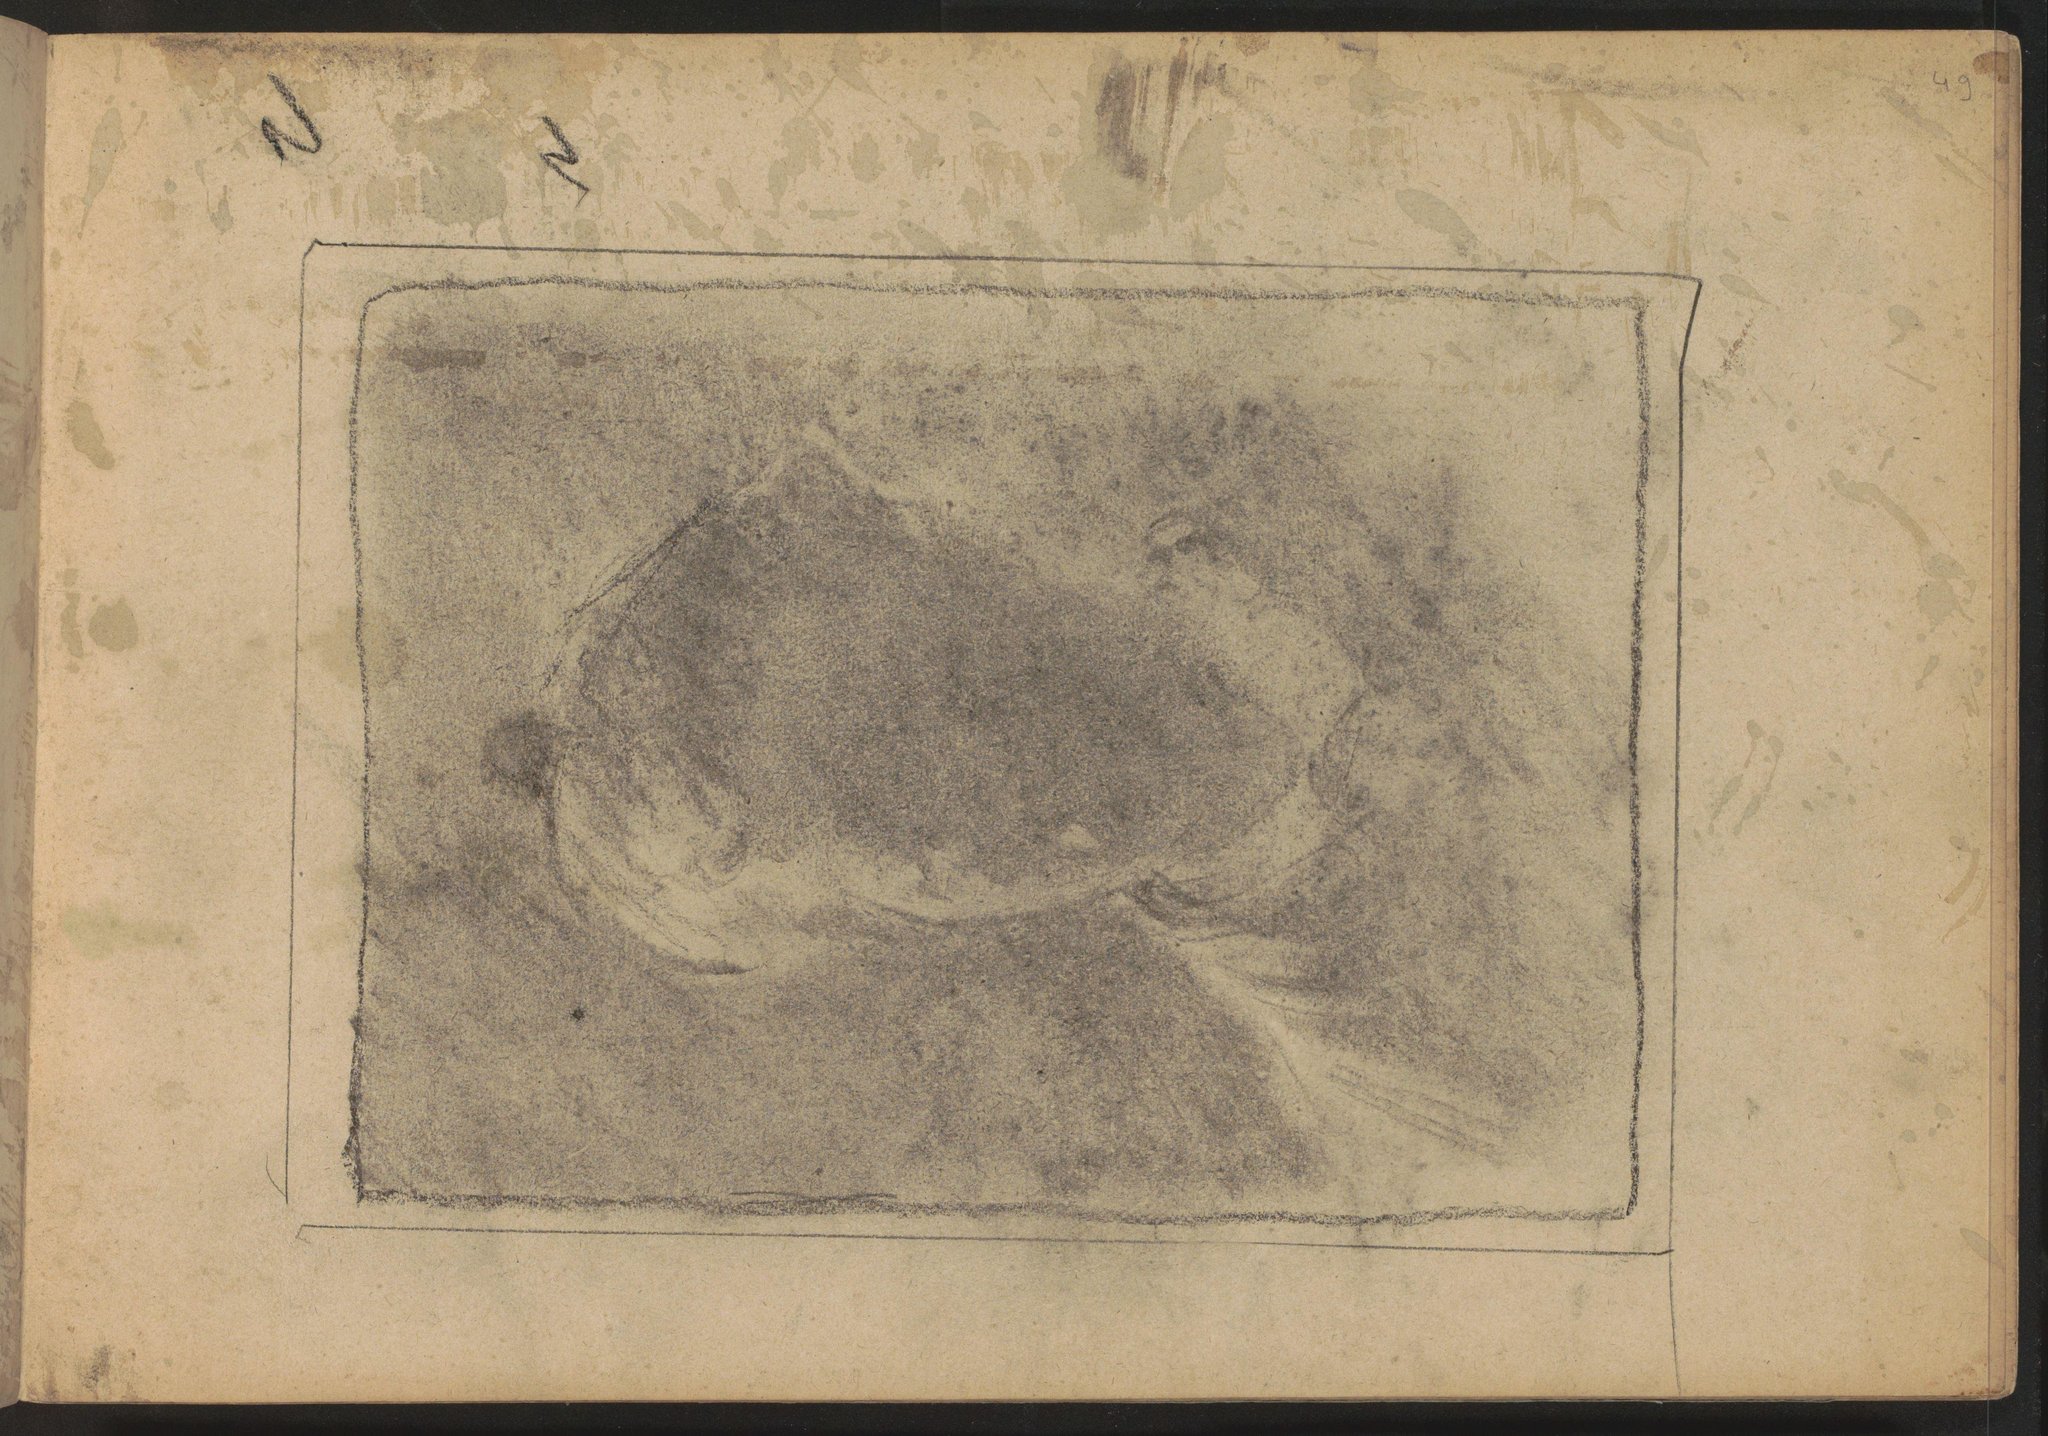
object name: sketchbook leaf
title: Portret van een onbekende vrouw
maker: willem witsen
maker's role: draughtsman, painter, print maker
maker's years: 1860-1923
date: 1884-1887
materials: chalk, paper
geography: ewijkshoeve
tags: anonymous historical person portrayed - bb - woman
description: Pagina 49 uit een schetsboek met 29 bladen.